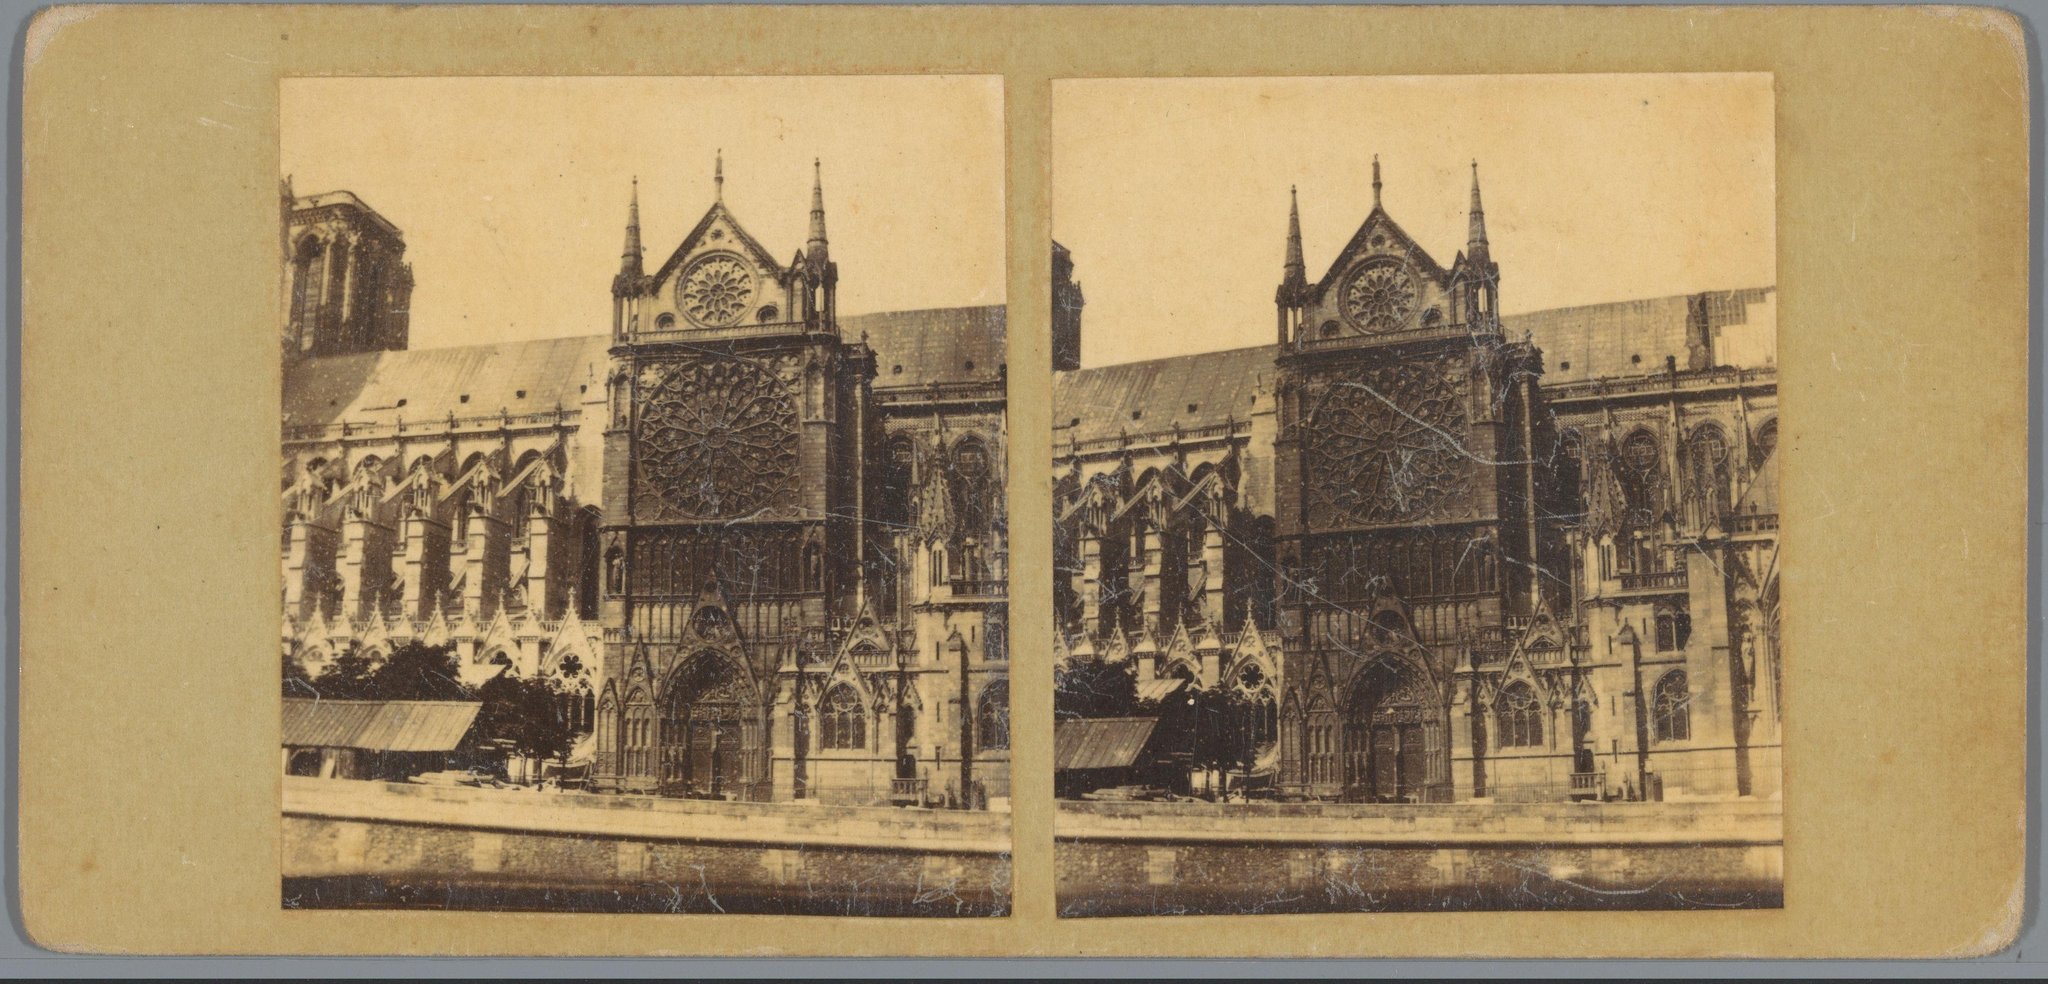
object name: stereograph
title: Gezicht op de Notre-Dame in Parijs met een rozetvenster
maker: Anonymous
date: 1855-1860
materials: cardboard, photographic support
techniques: albumen print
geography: paris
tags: church-window, e.g. rose-window, church (exterior)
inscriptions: inscription: ‘Paris, Cote meridional de Notre Dame’